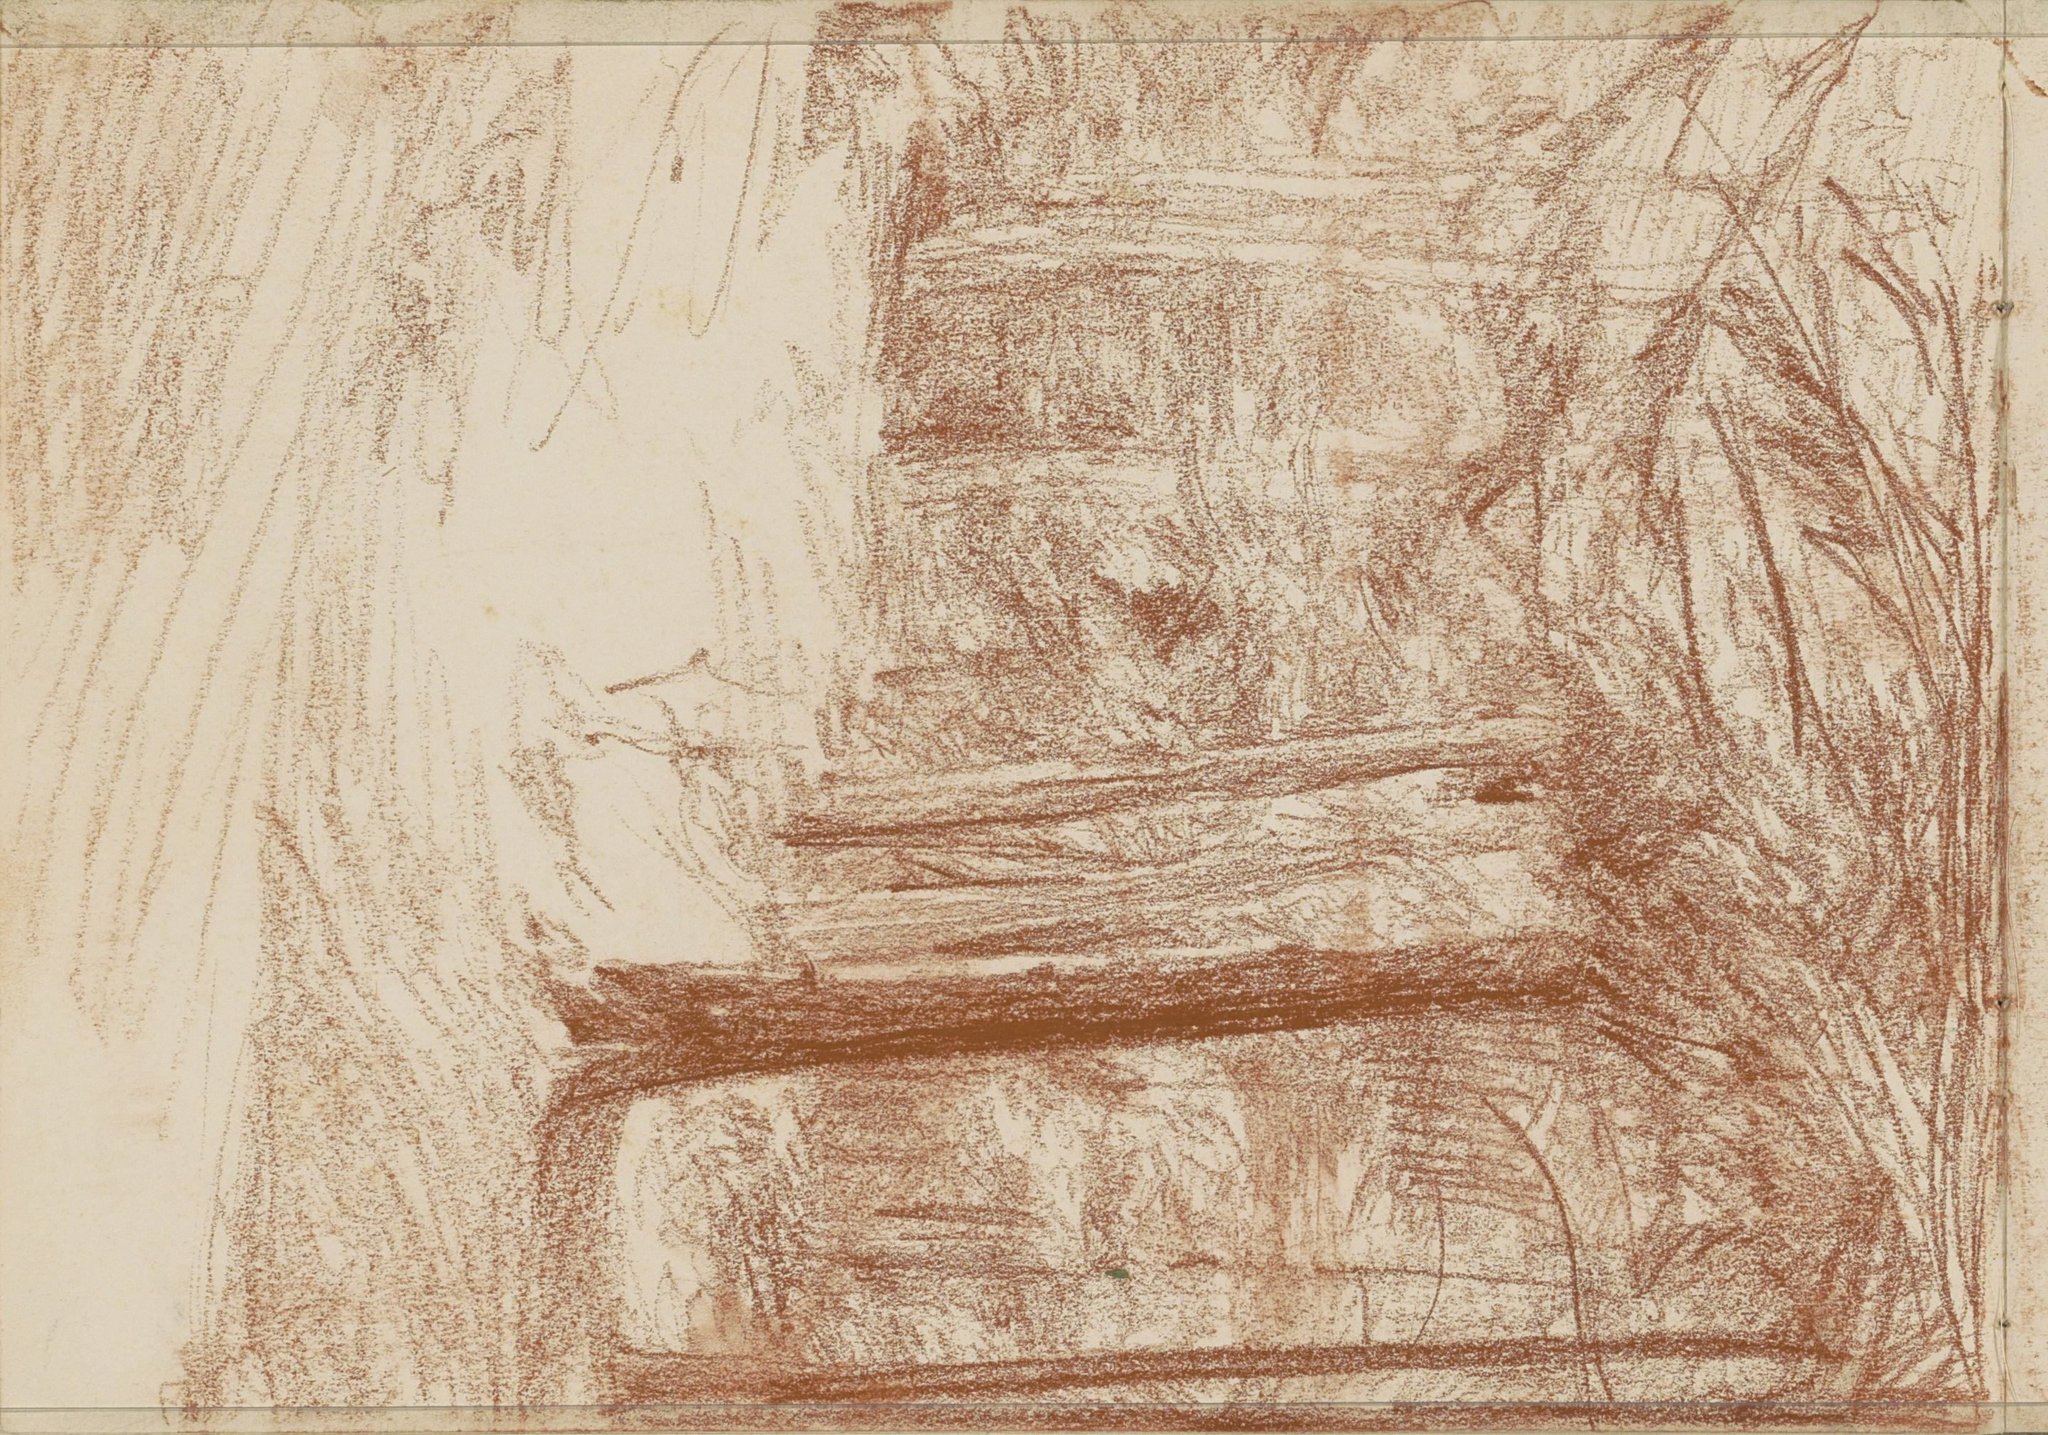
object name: sketchbook leaf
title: Bospad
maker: a.a.l. de grammont-hubrecht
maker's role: draughtsman, painter, print maker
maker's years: 1855-1913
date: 1865-1913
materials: chalk, paper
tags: forest path or lane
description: Blad 61 verso uit een schetsboek met 68 bladen.